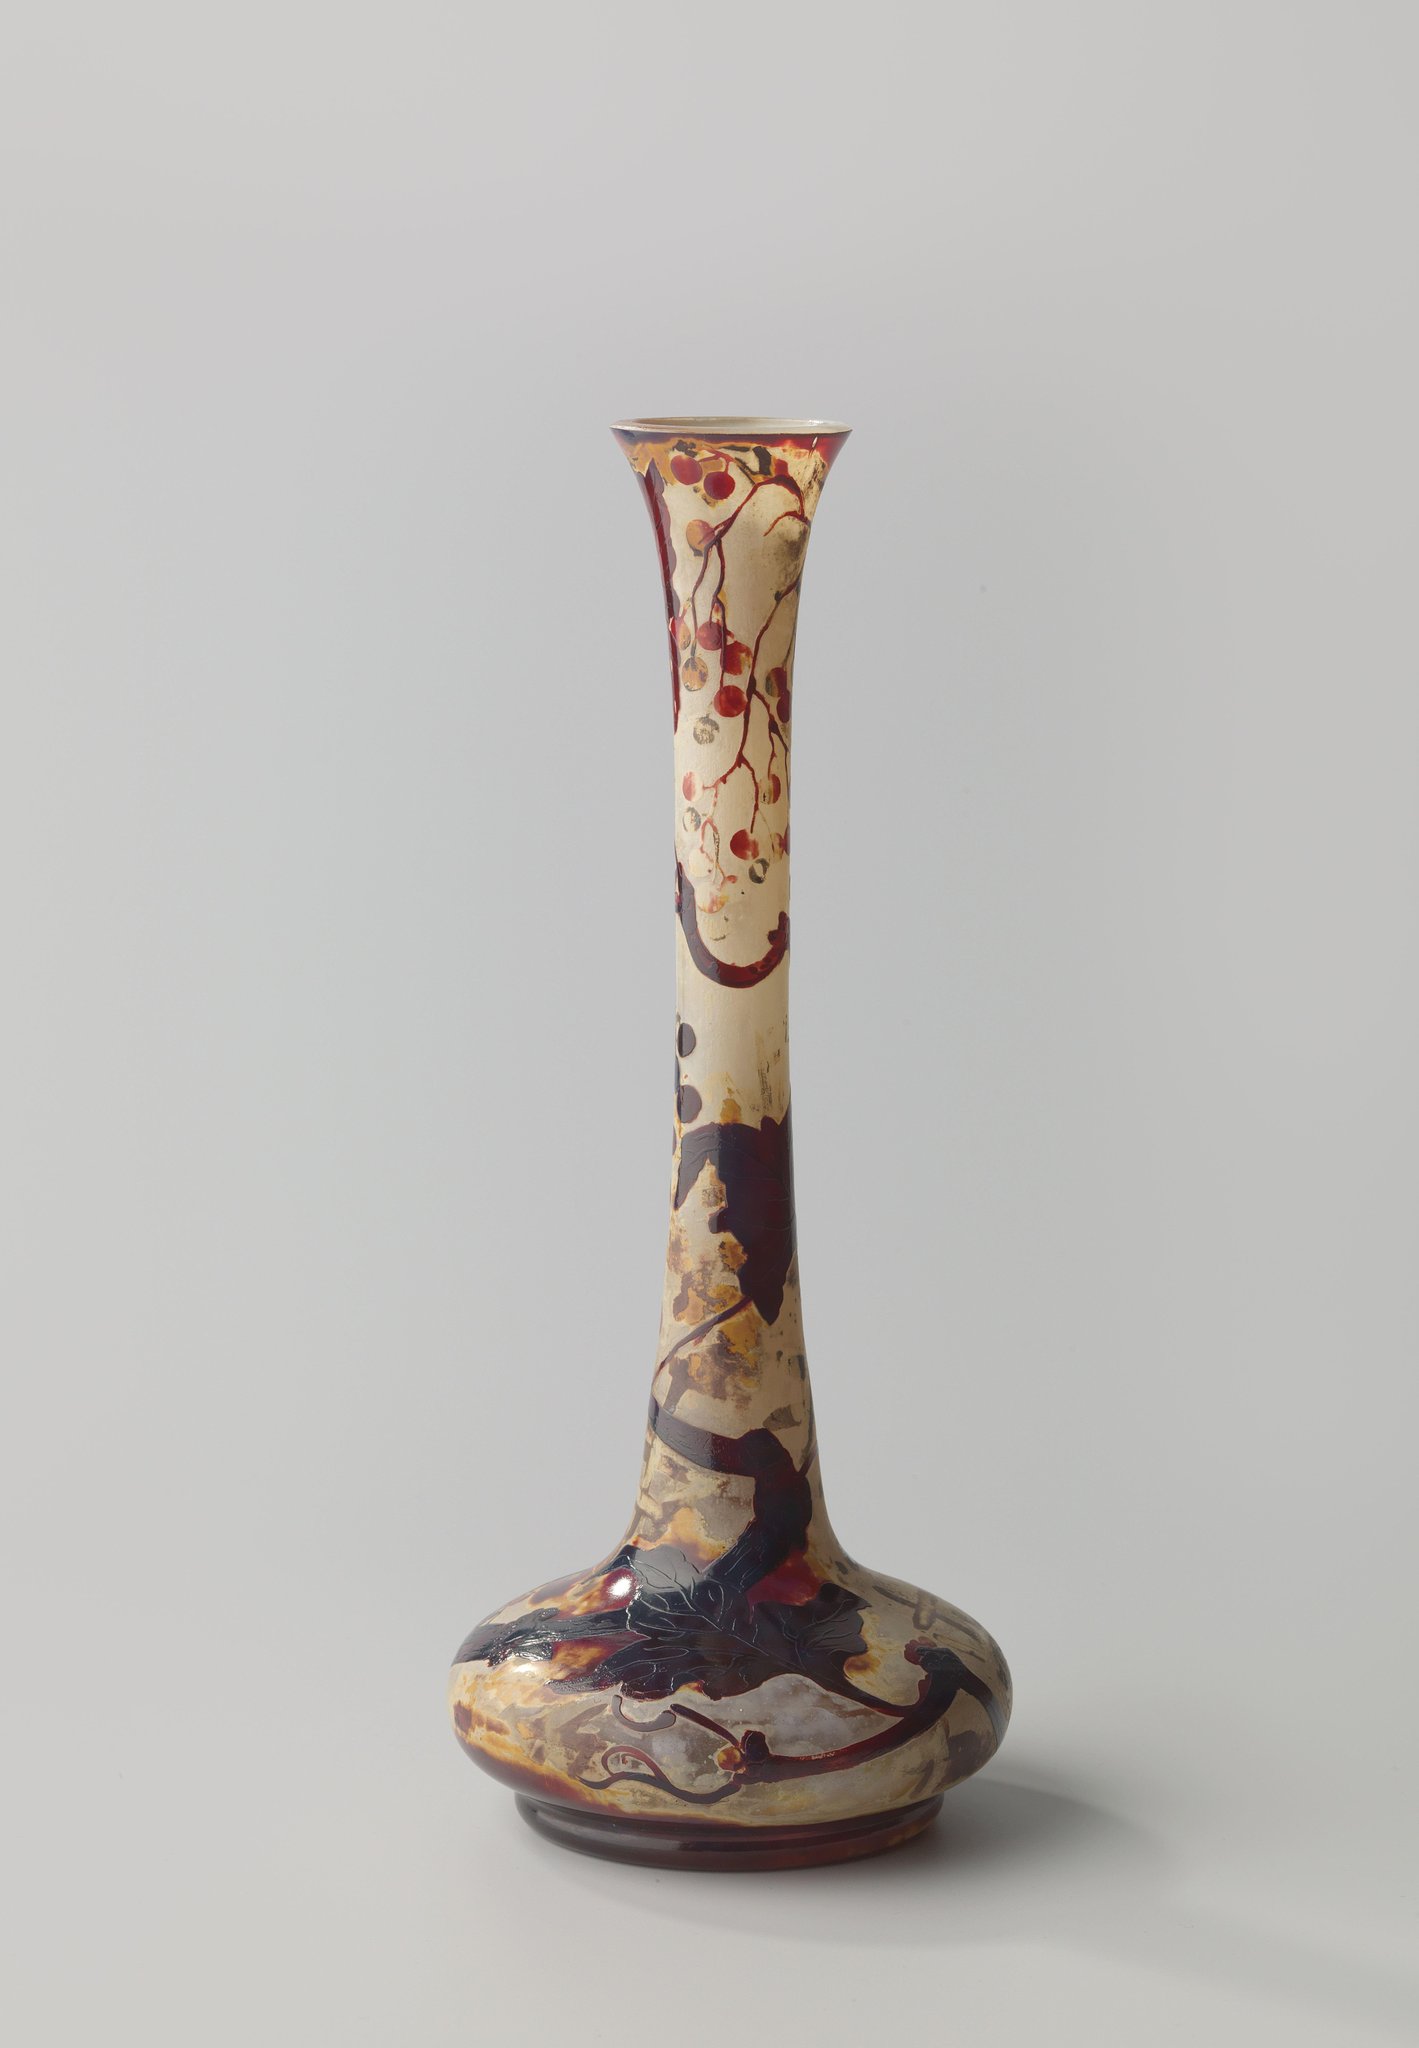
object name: vase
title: Vaas met takken vlier met zwarte bessen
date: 1900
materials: glass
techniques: etching, glassblowing, grinding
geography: croismare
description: Vlakke bodem, lage voet, ingedrukt bolvormig lichaam, overgaande in een hoge, aan de bovenzijde uitlopende hals. Op een bruine en ivoorkleurige, mat geëtste Überfang, in reliëf, in rood en zwart opgesmolten glaspoeder, een decor van takken vlier met zwarte bessen; De nerven van de bladeren met de naald geëtst. Op de bodem de signatuur Muller Croismare.